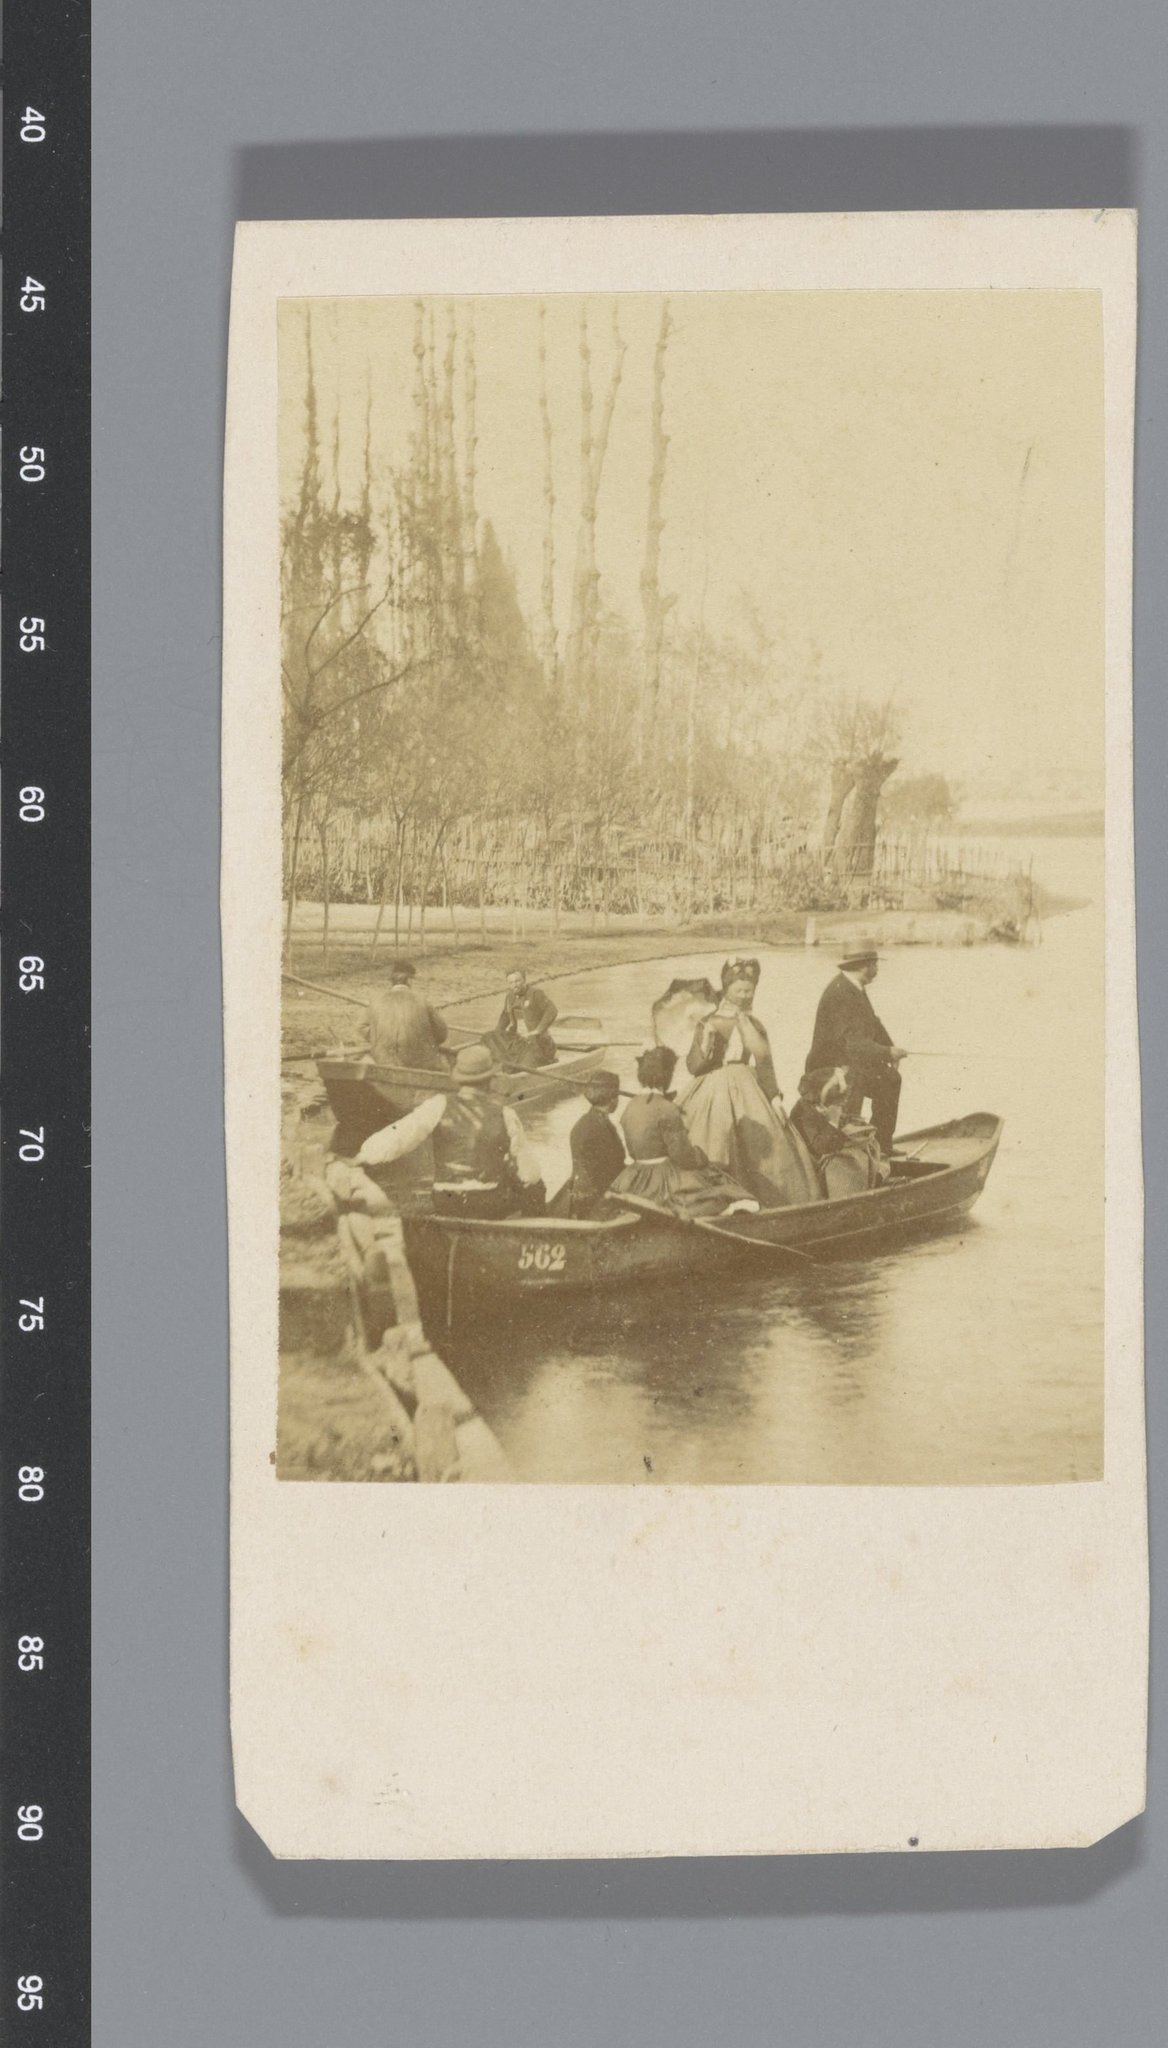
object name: photograph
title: Gezelschap in twee roeiboten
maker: Anonymous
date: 1865-1870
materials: cardboard, paper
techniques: albumen print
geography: france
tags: rowing-boat, canoe, etc., france